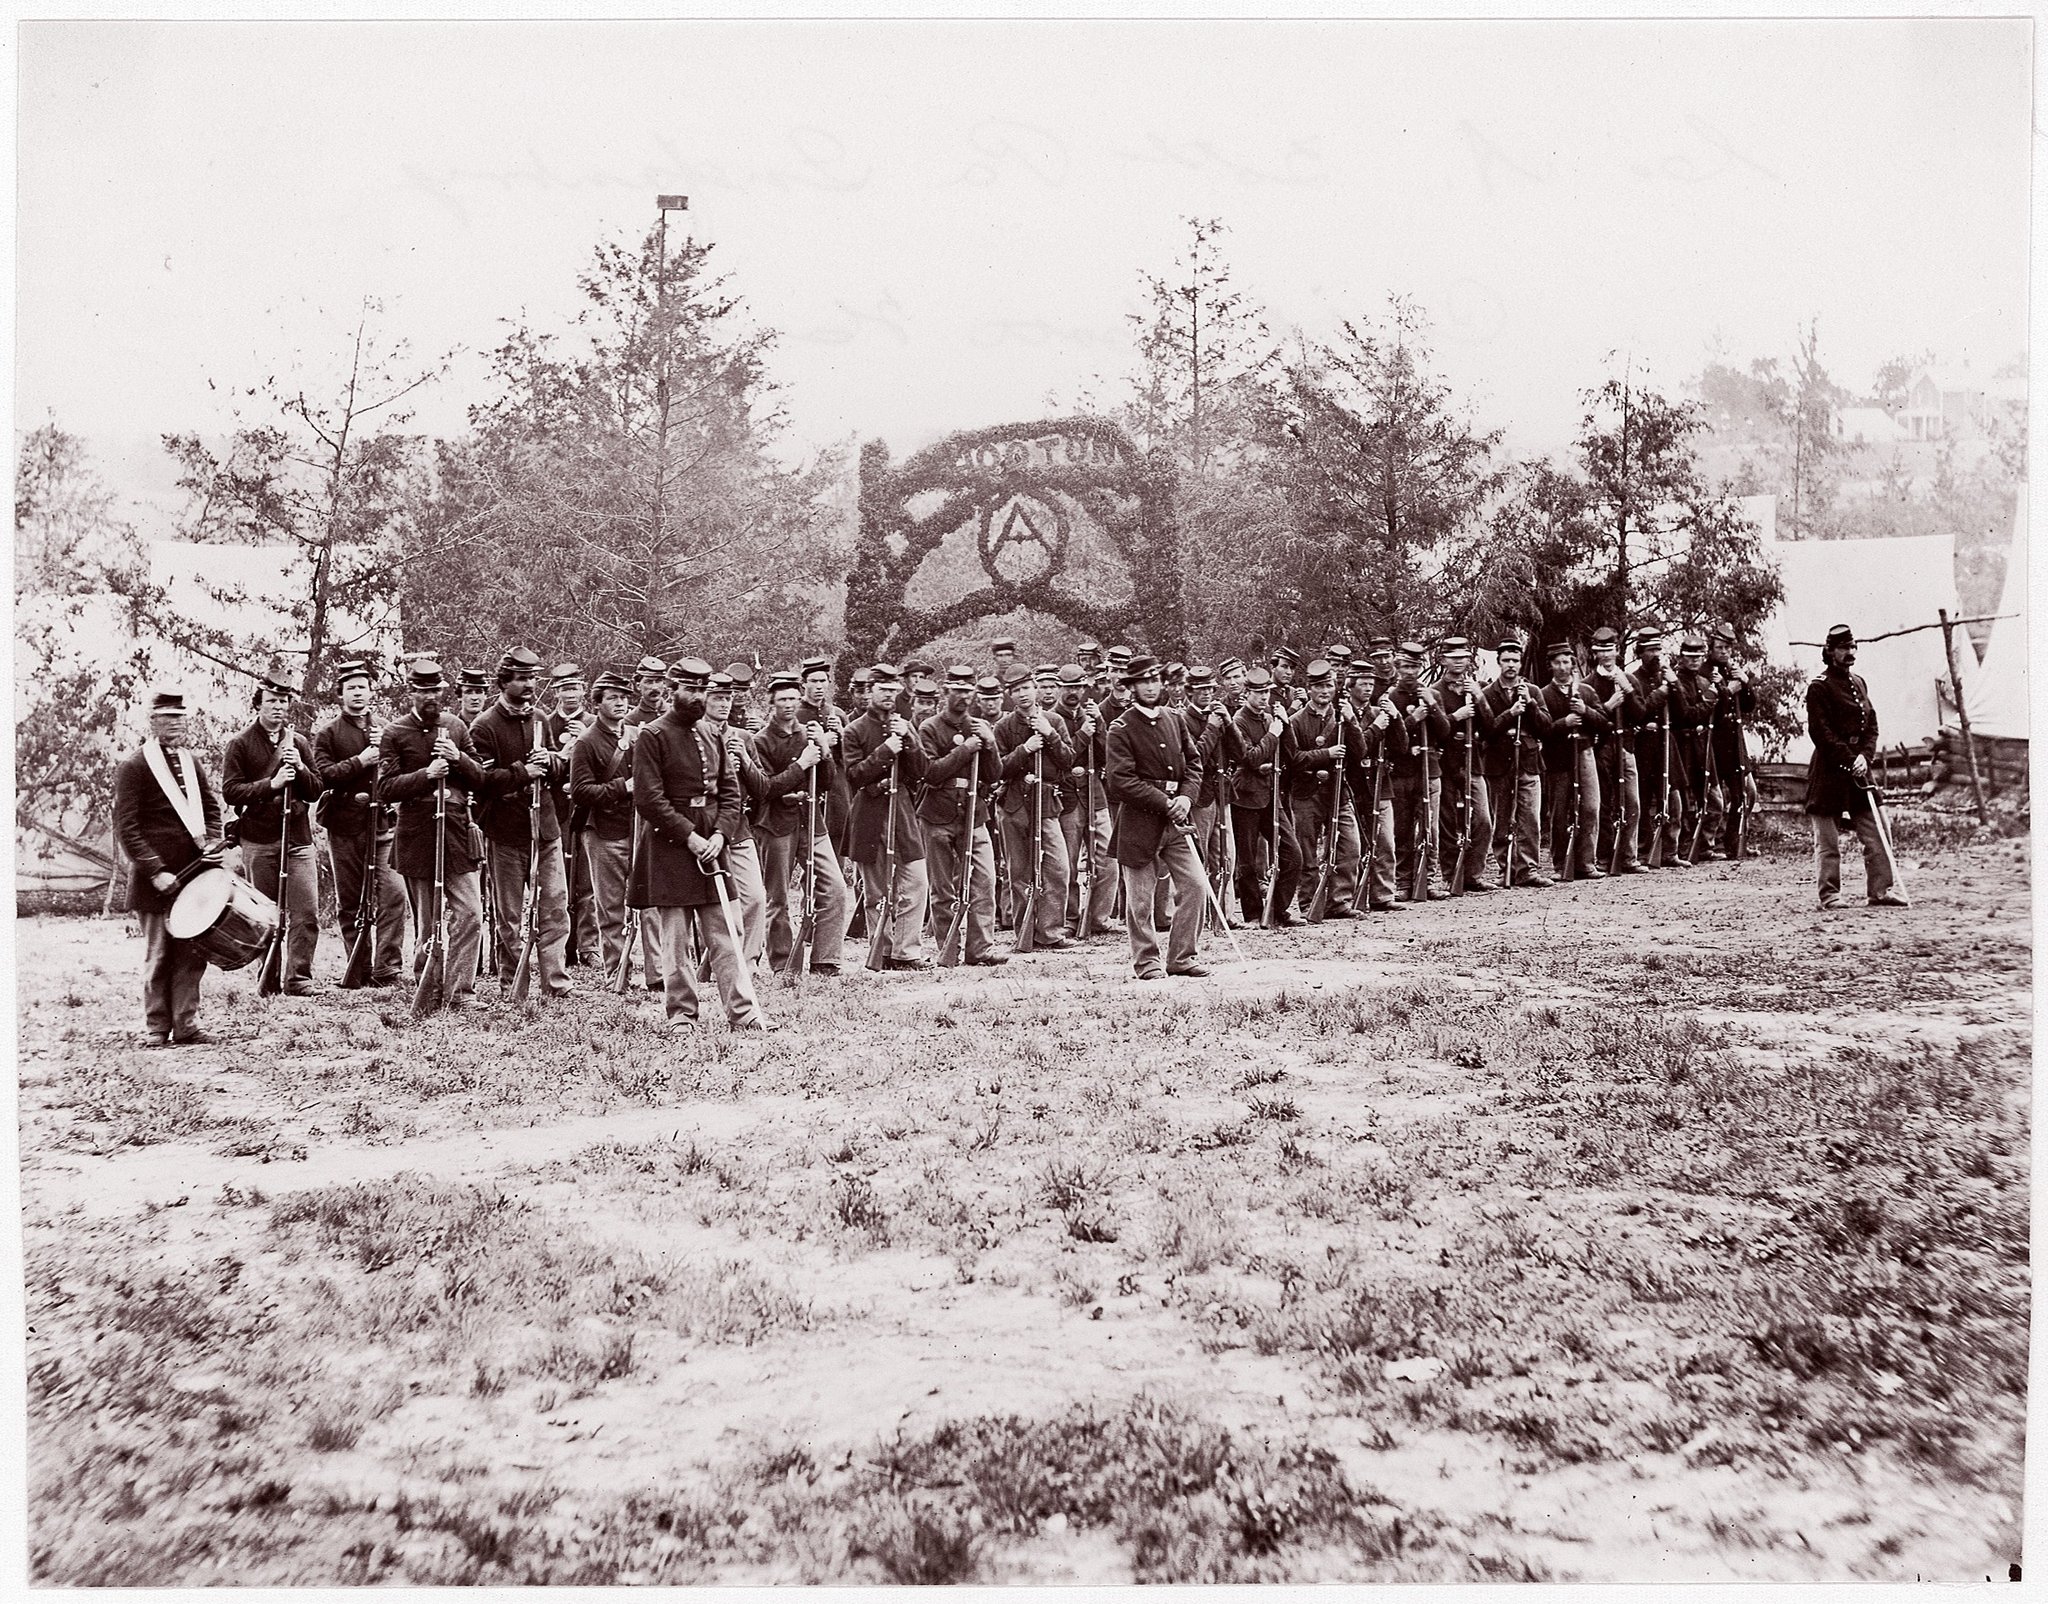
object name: photograph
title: [Company A, 30th Pennsylvania Infantry, Captain Mott Hooton]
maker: Anonymous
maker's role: artist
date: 1861-1865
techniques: albumen silver print, glass negative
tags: army,soldiers,american civil war